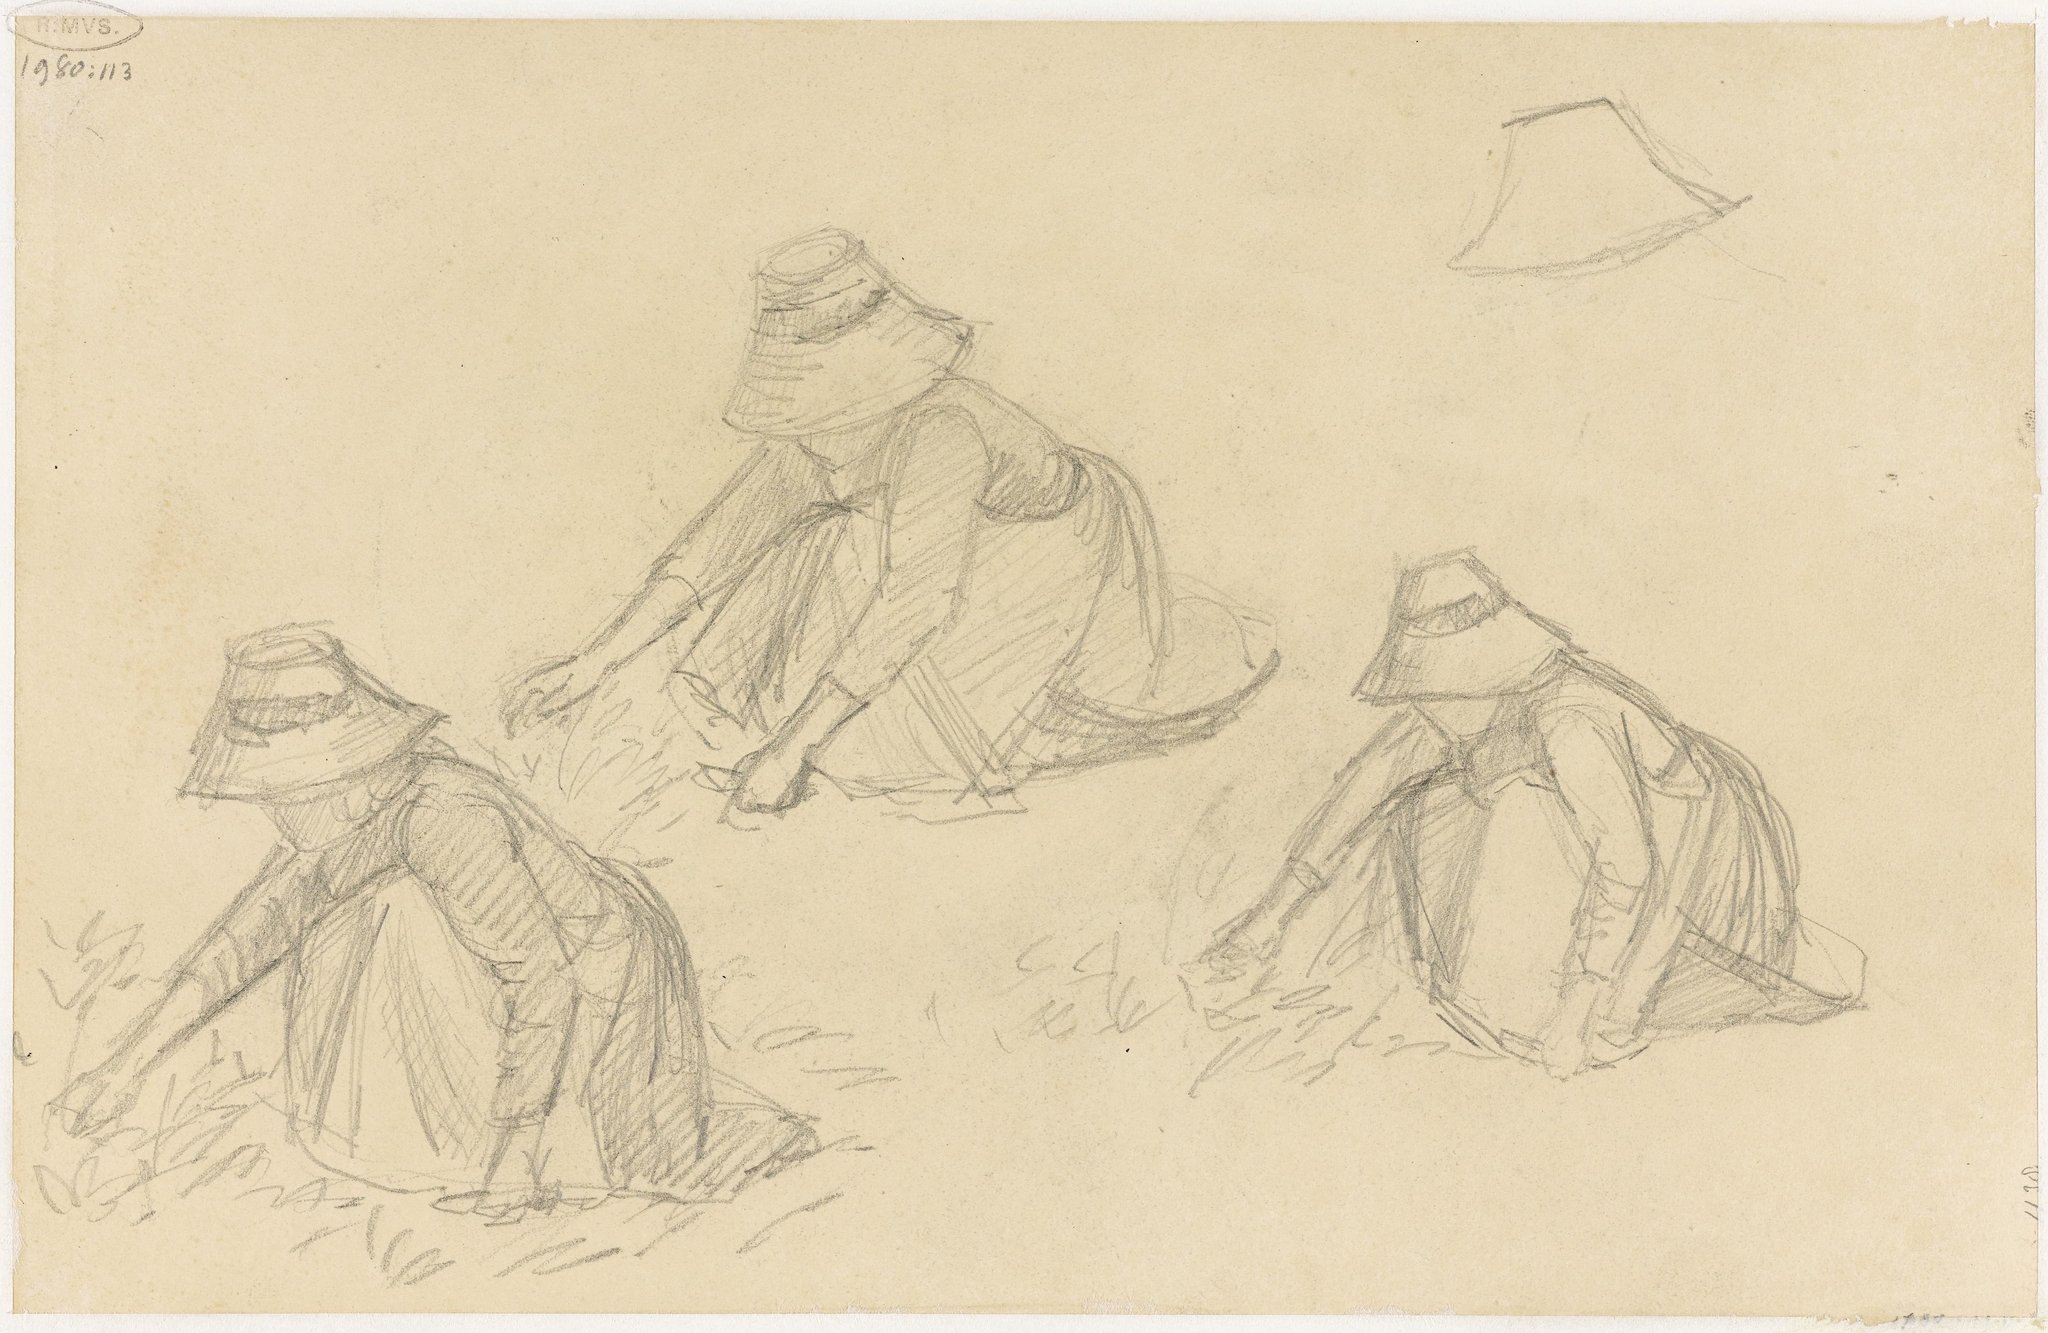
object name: drawing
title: Drie studies van een hurkende vrouw op het land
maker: jozef israëls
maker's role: draughtsman, painter, print maker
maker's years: 1824-1911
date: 1834-1911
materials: paper, pencil